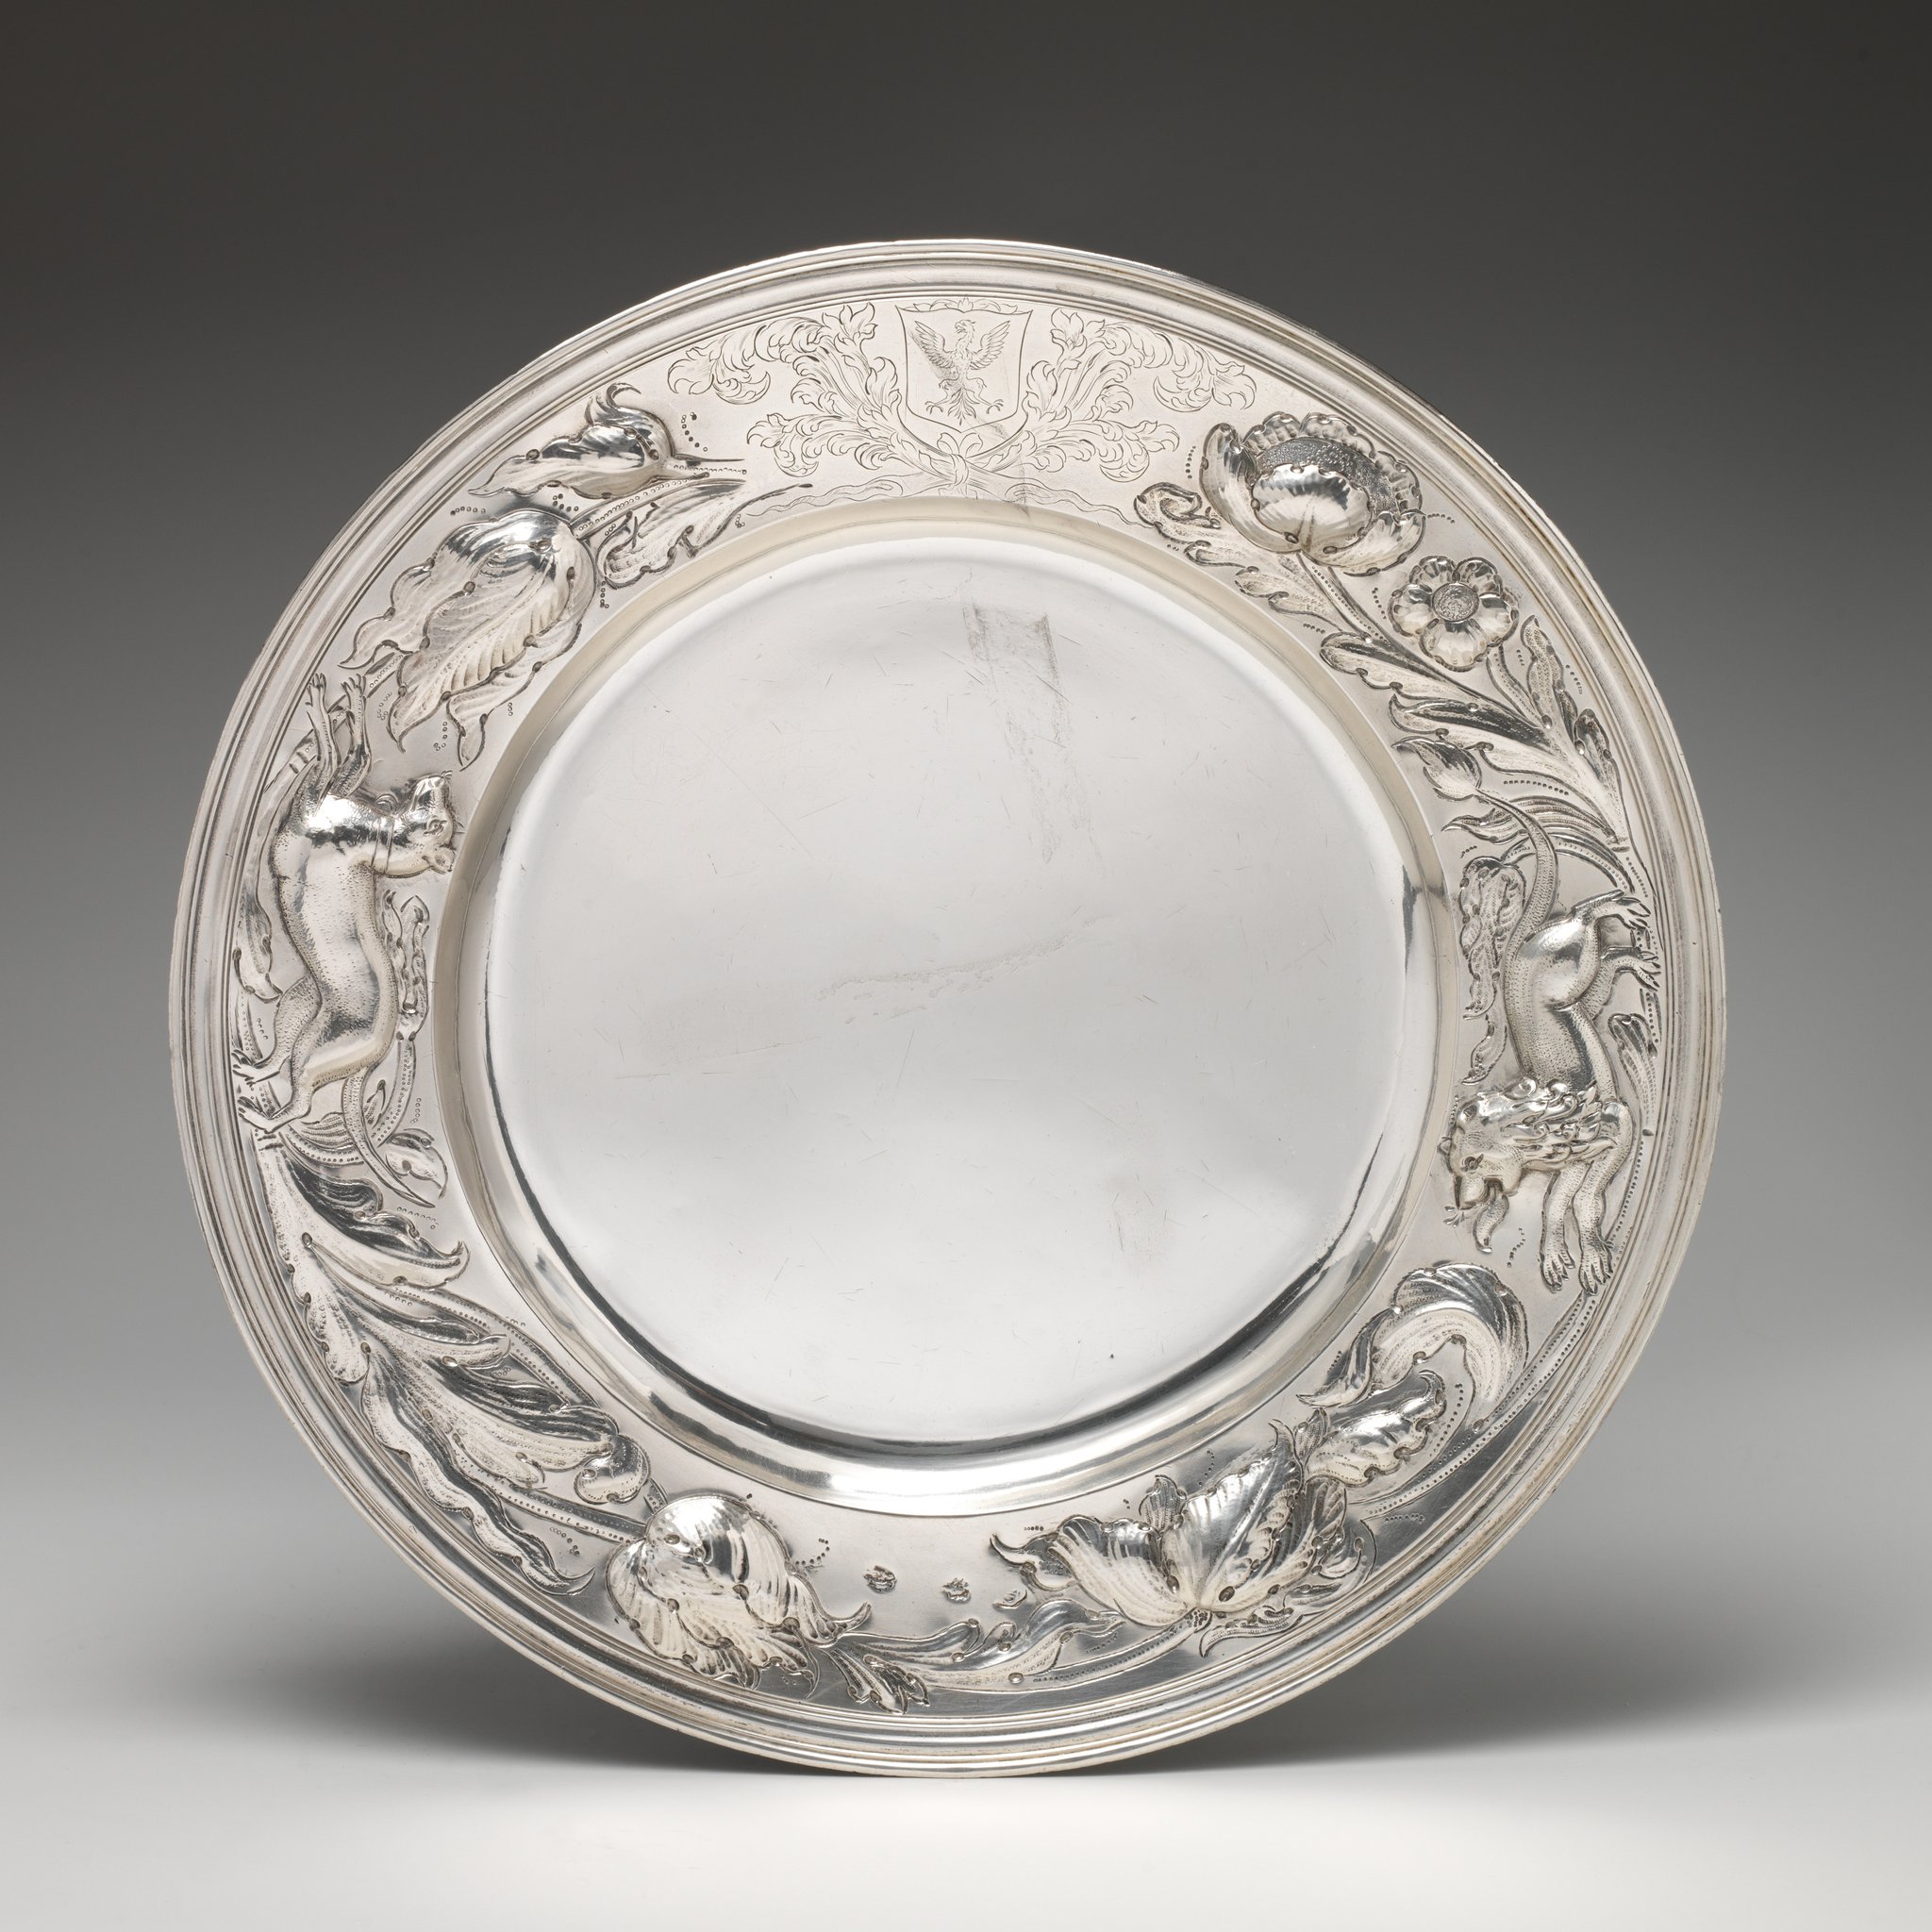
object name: plate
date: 1677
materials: silver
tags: animals,flowers,coat of arms